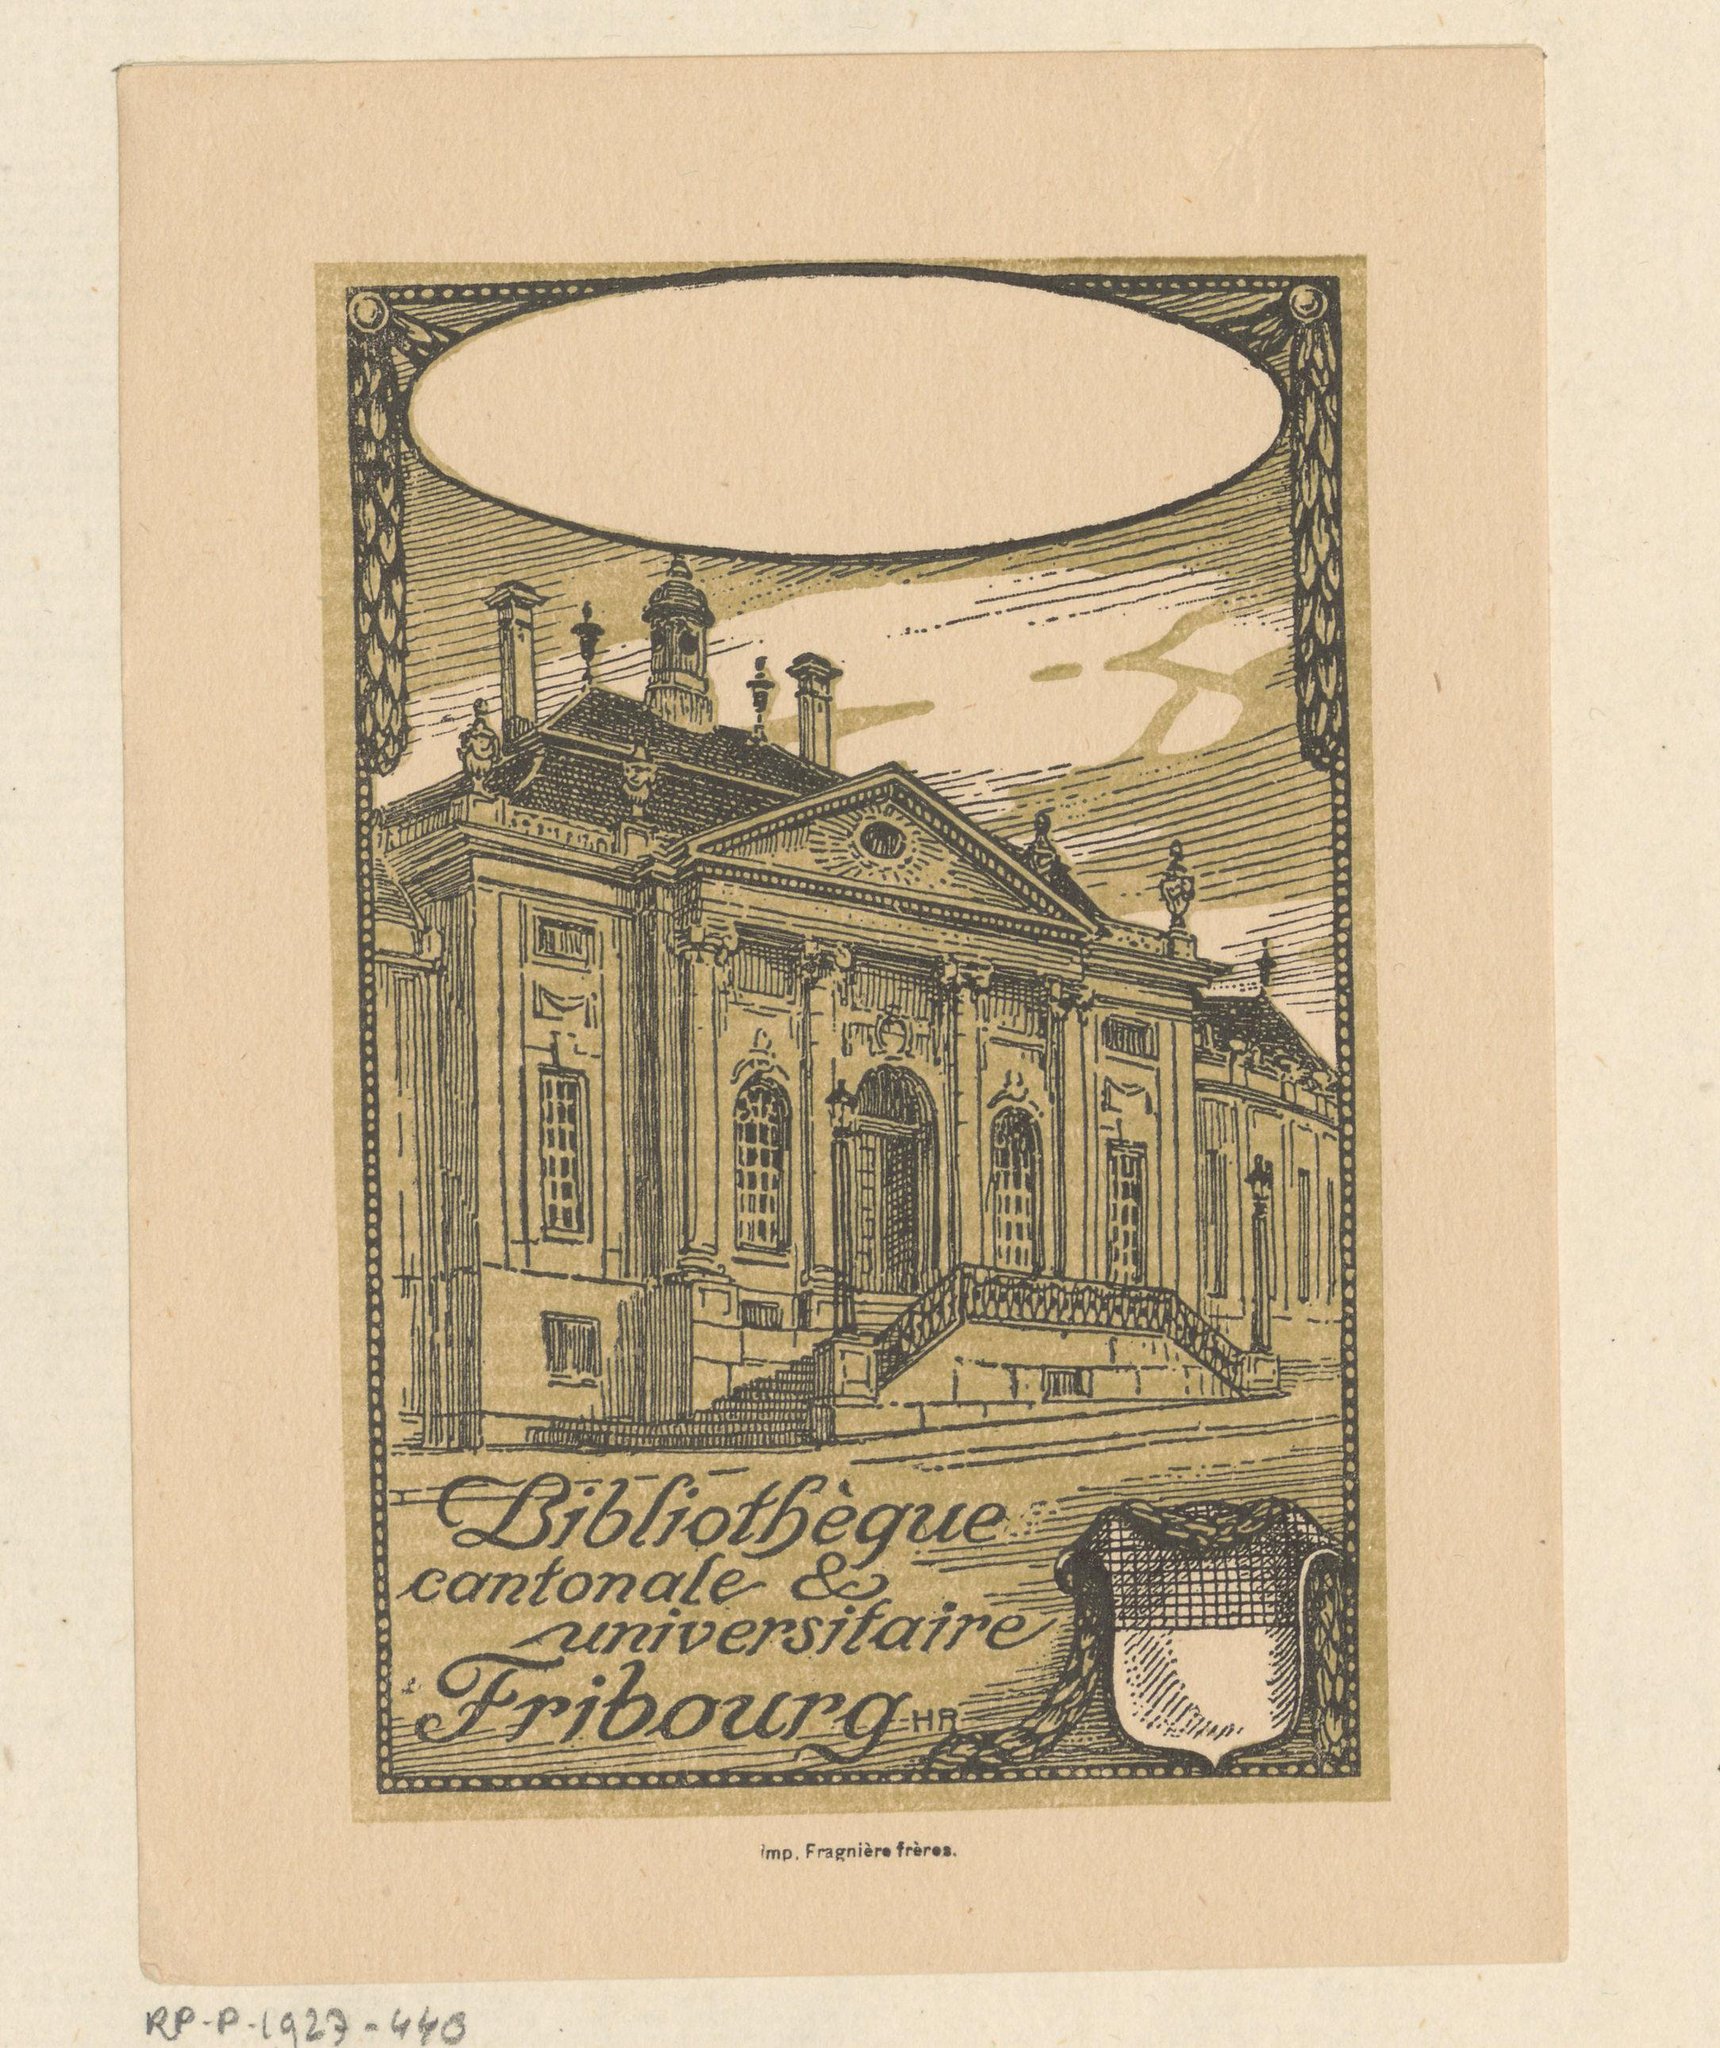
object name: bookplate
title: Ex libris van de universiteitsbibliotheek van Fribourg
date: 1858-1903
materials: paper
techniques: planographic printing, printing block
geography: switzerland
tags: public library, armorial bearing, heraldry